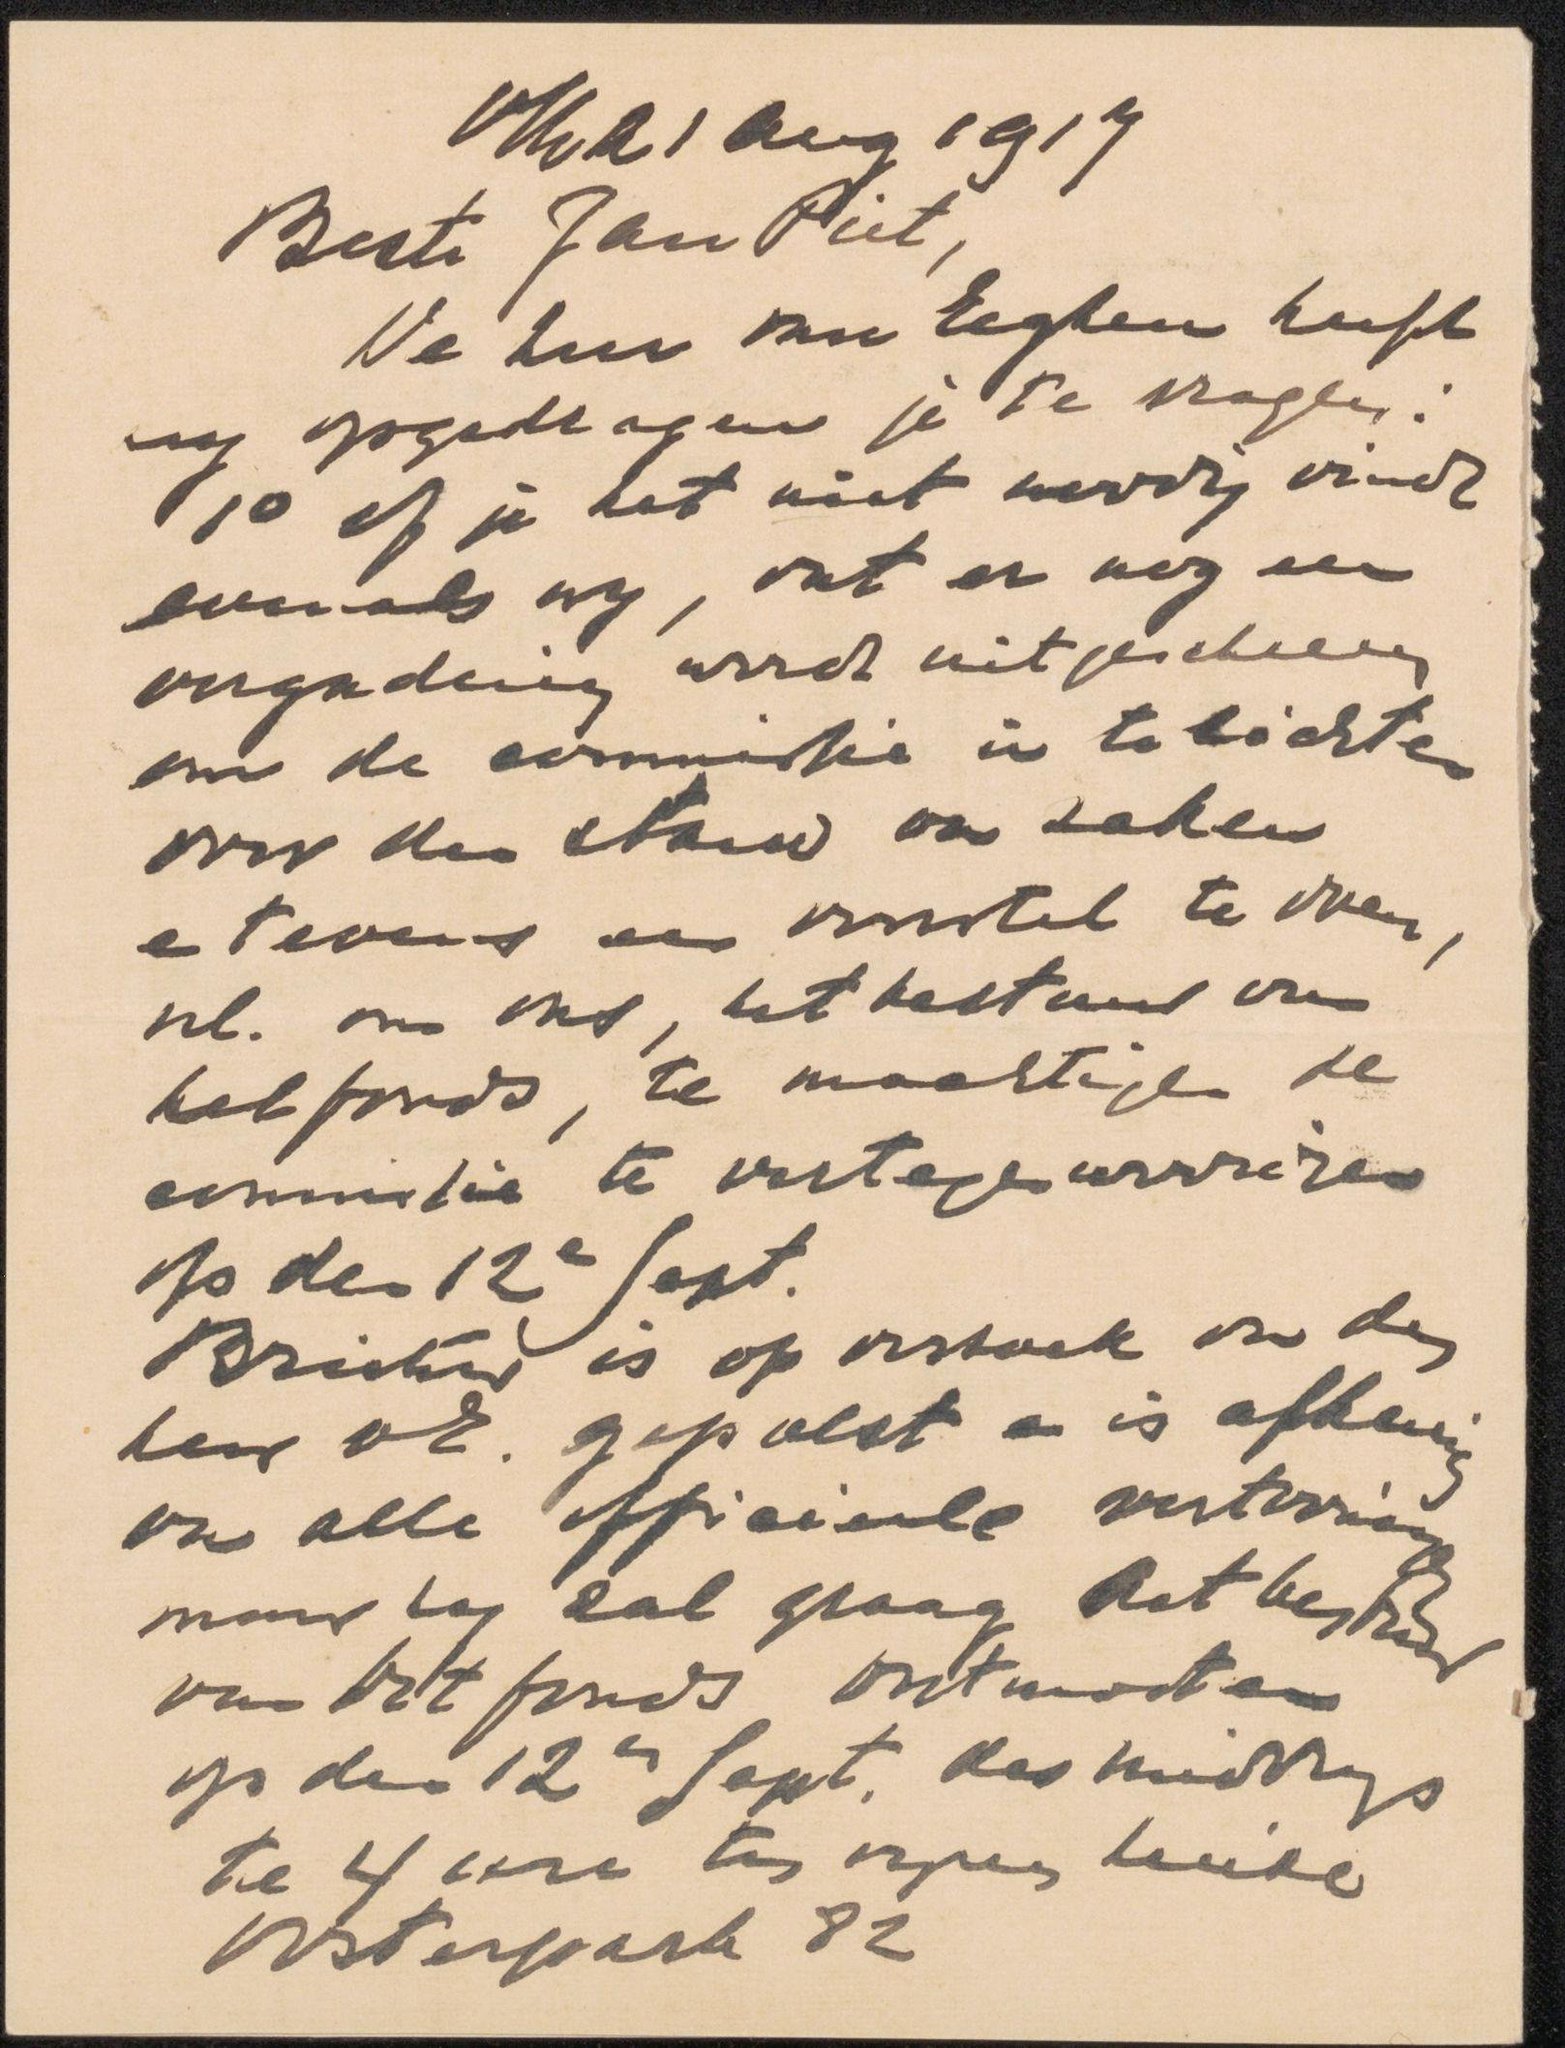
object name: letter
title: Brief aan Jan Veth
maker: willem witsen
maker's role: draughtsman, painter, print maker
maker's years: 1860-1923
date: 1917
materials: ink, paper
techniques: pen, writing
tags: rotterdam, george hendrik breitner, dordrecht, amsterdam, painter, print maker, draughtsman, designer, jan veth, the hague, isaac israels, money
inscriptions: collector's mark: ‘RPK’